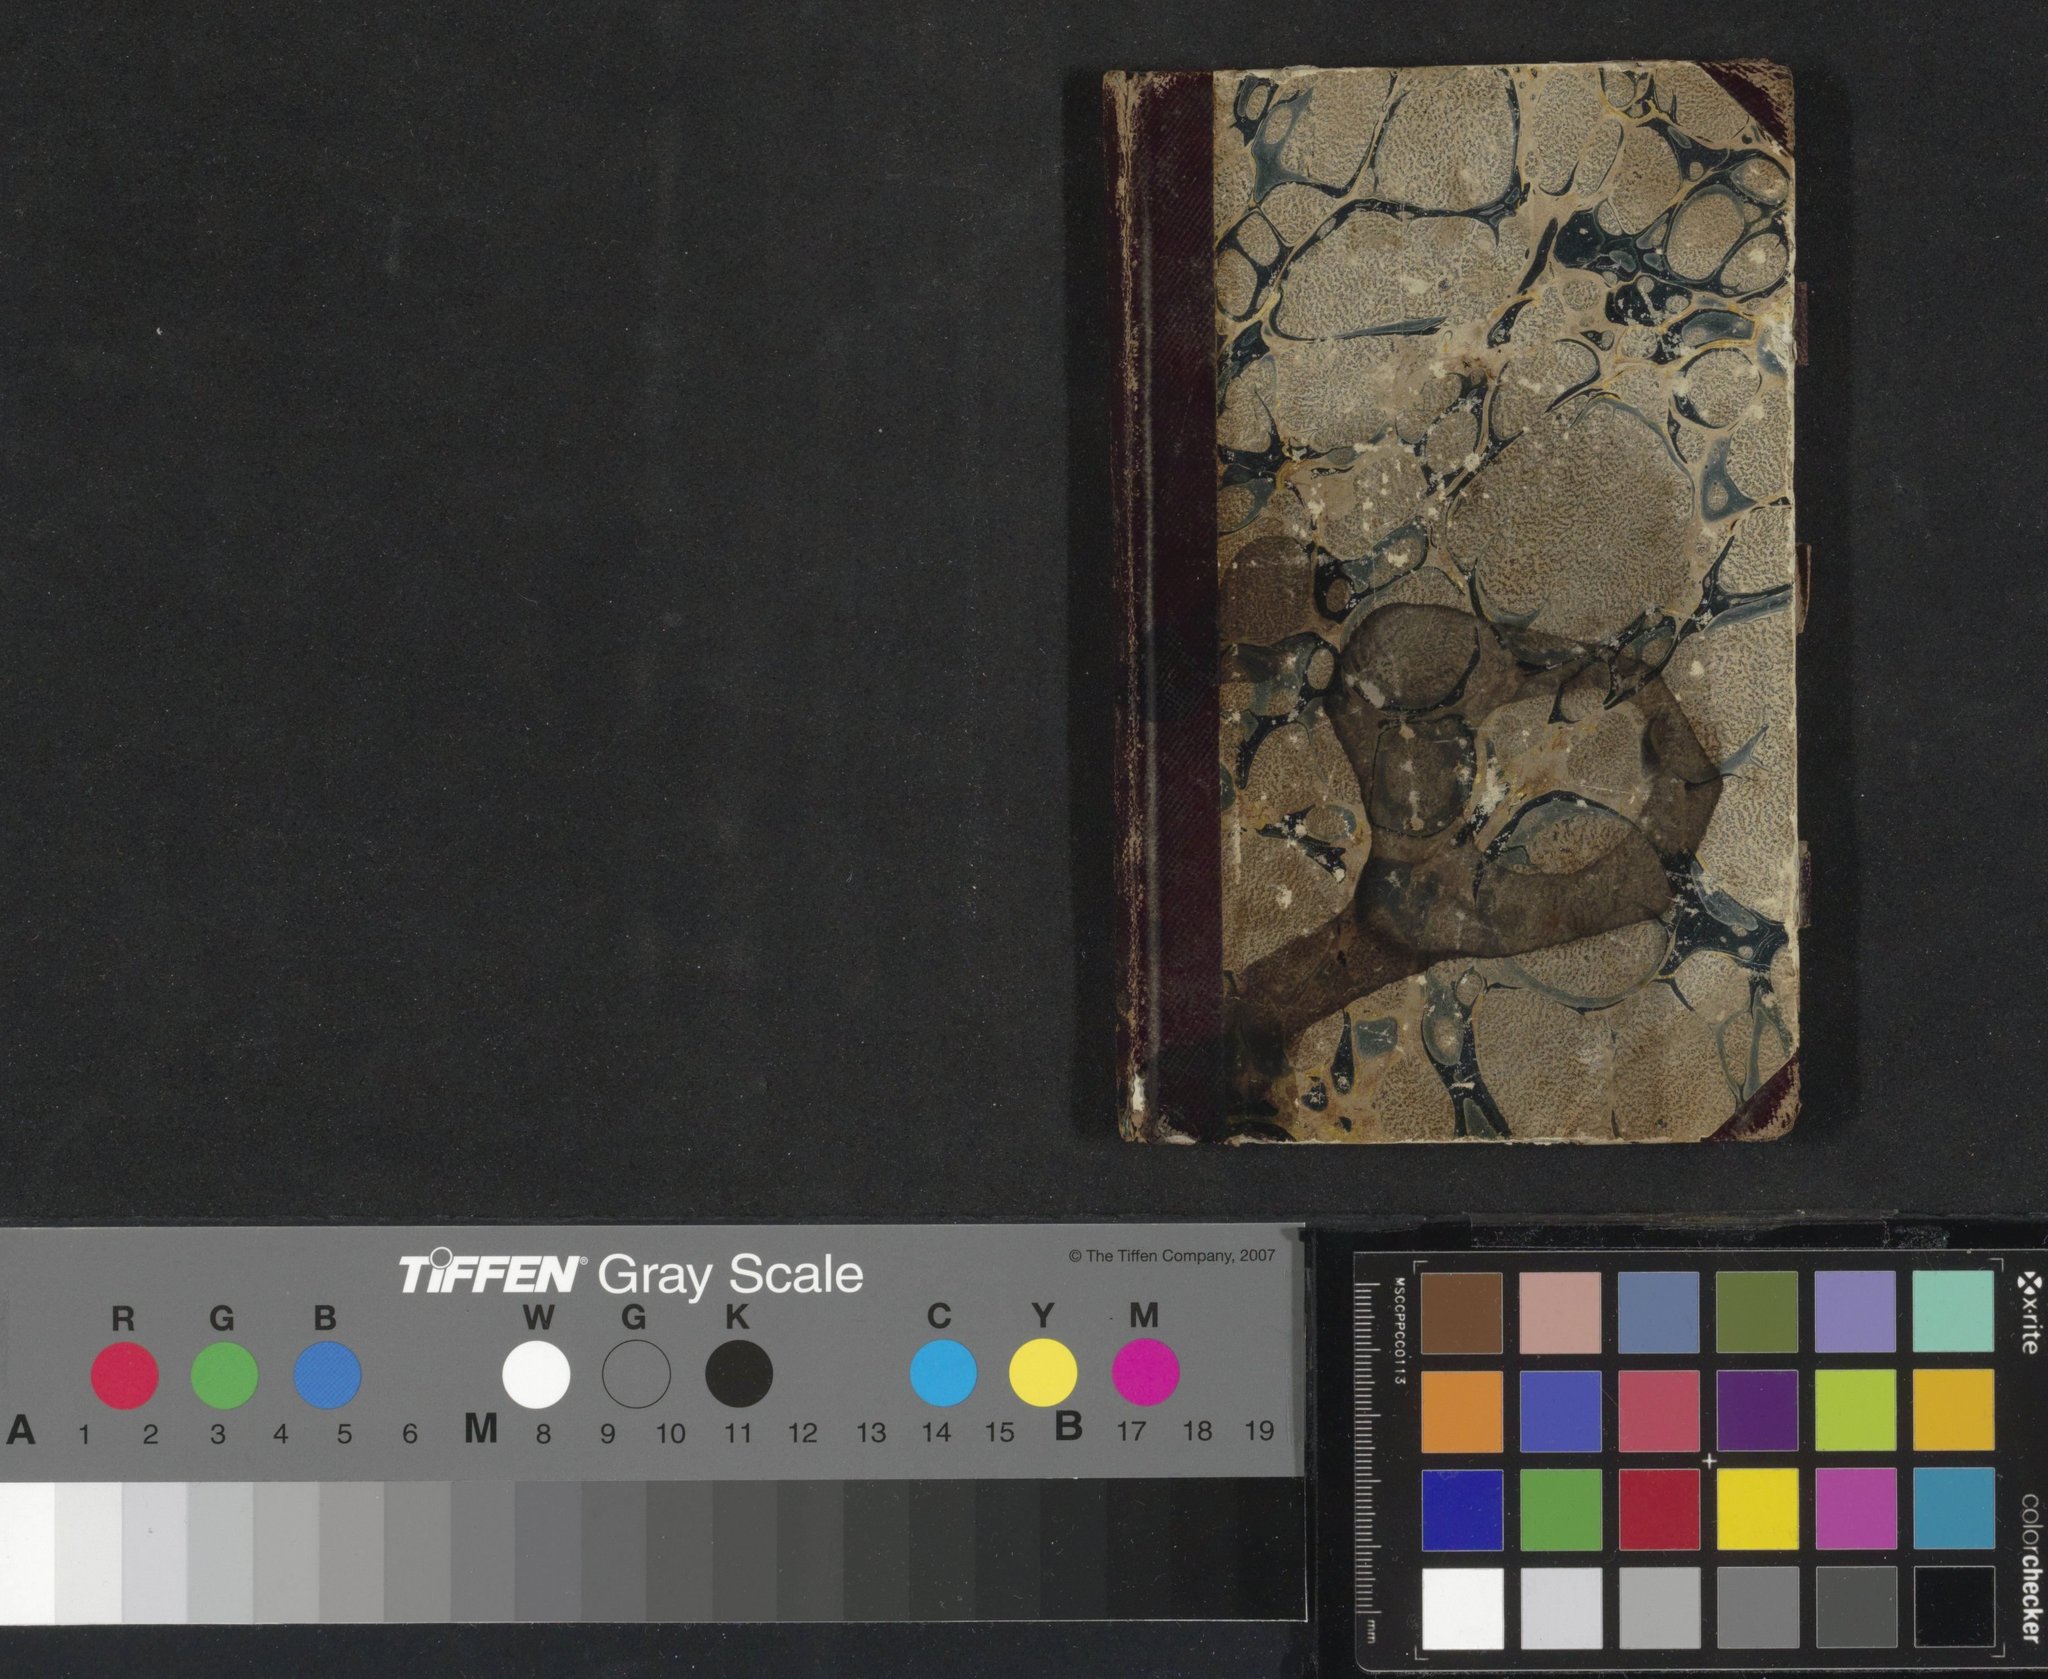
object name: sketchbook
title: Schetsboek met 19 bladen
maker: Anonymous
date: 1802-1874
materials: cardboard, leather, paper, pencil, watercolor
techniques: brush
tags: trees, farmers - aa - female farmer, farmer's wife, windmill, farm (building)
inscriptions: collector's mark: Lugt 2228a, annotation: ‘30 ct’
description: Schetsboek bestaande uit 19 bladen met bomen, landschappen, boerderijen en een molen. In de envelop voorin het schetsboek een los blad met figuurstudies.